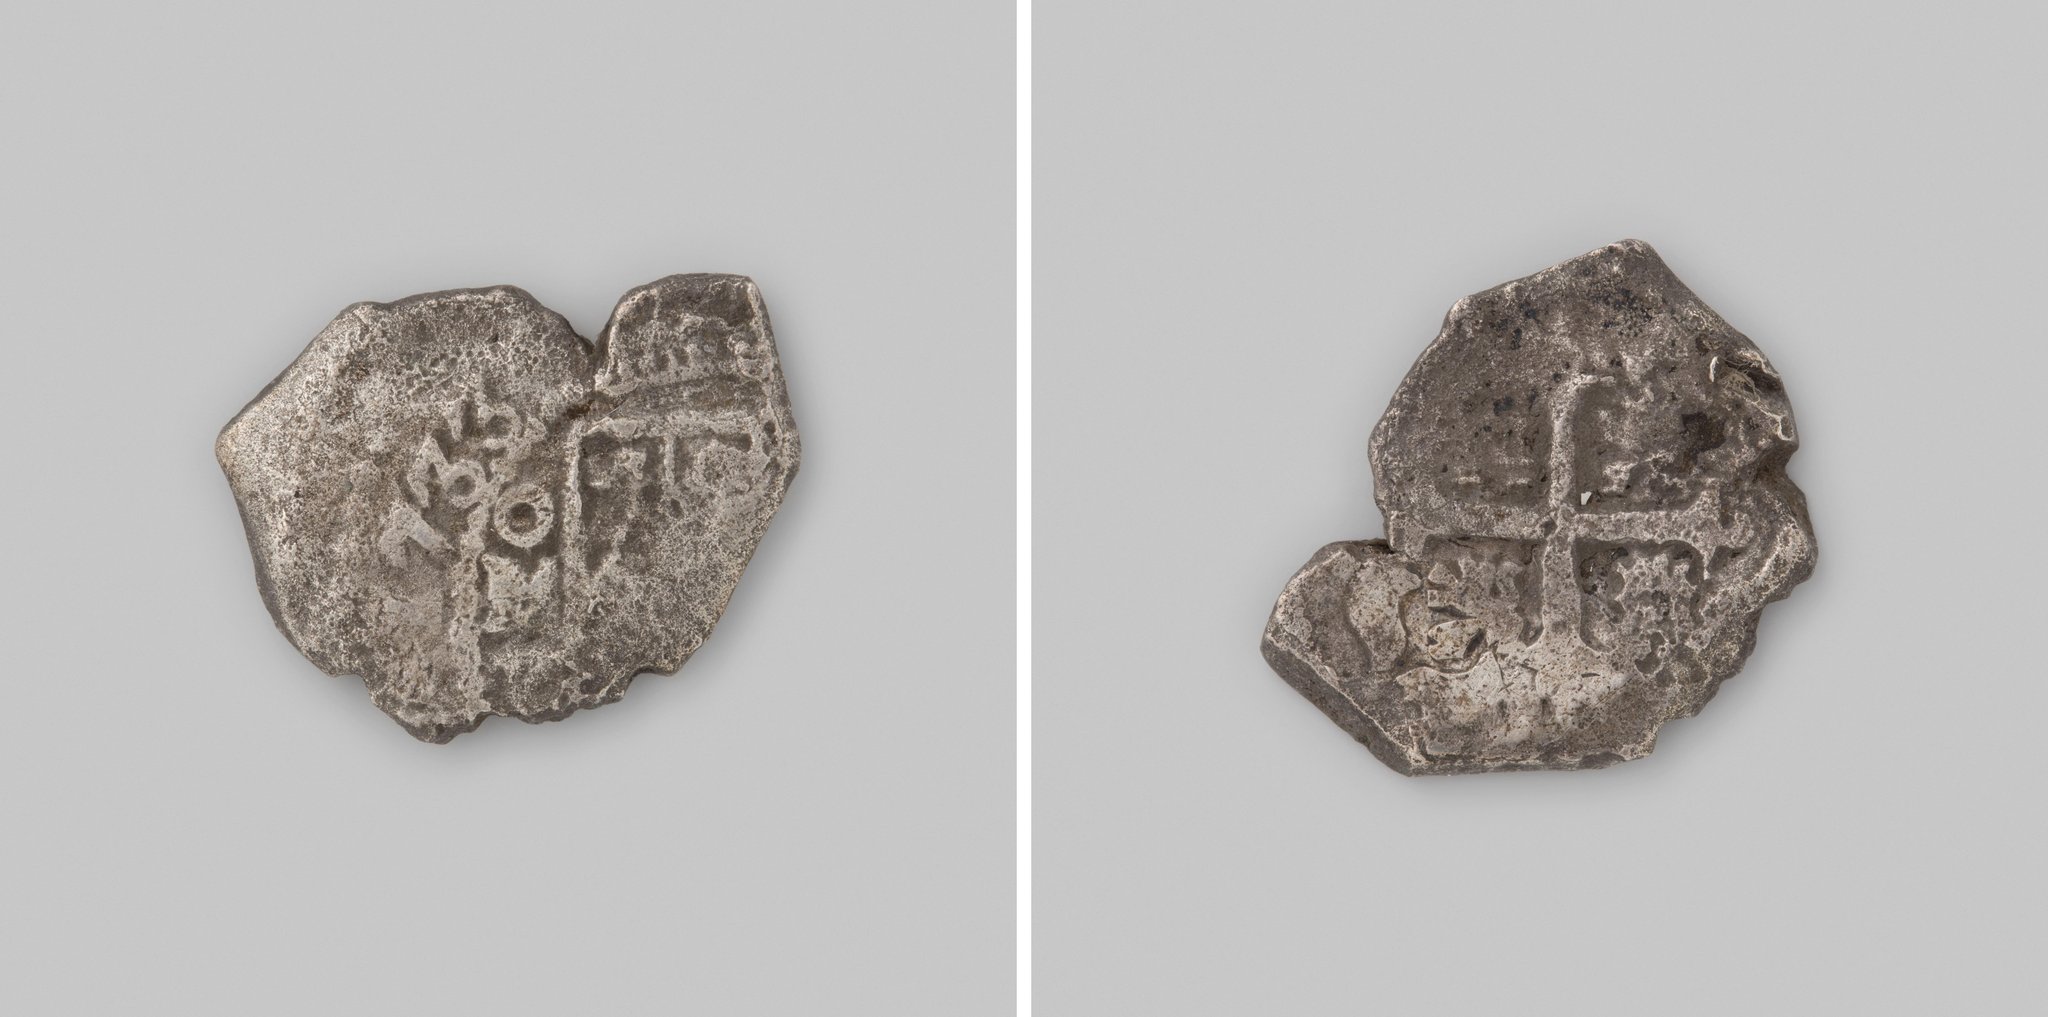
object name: vier reaal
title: Reaal van vieren, geslagen te Mexico, munt uit het wrak van de Oost-Indiëvaarder 't Vliegend Hart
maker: francisco de la pena flores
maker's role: essayeur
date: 1733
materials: silver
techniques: striking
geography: mexico city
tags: filips v (koning van spanje)